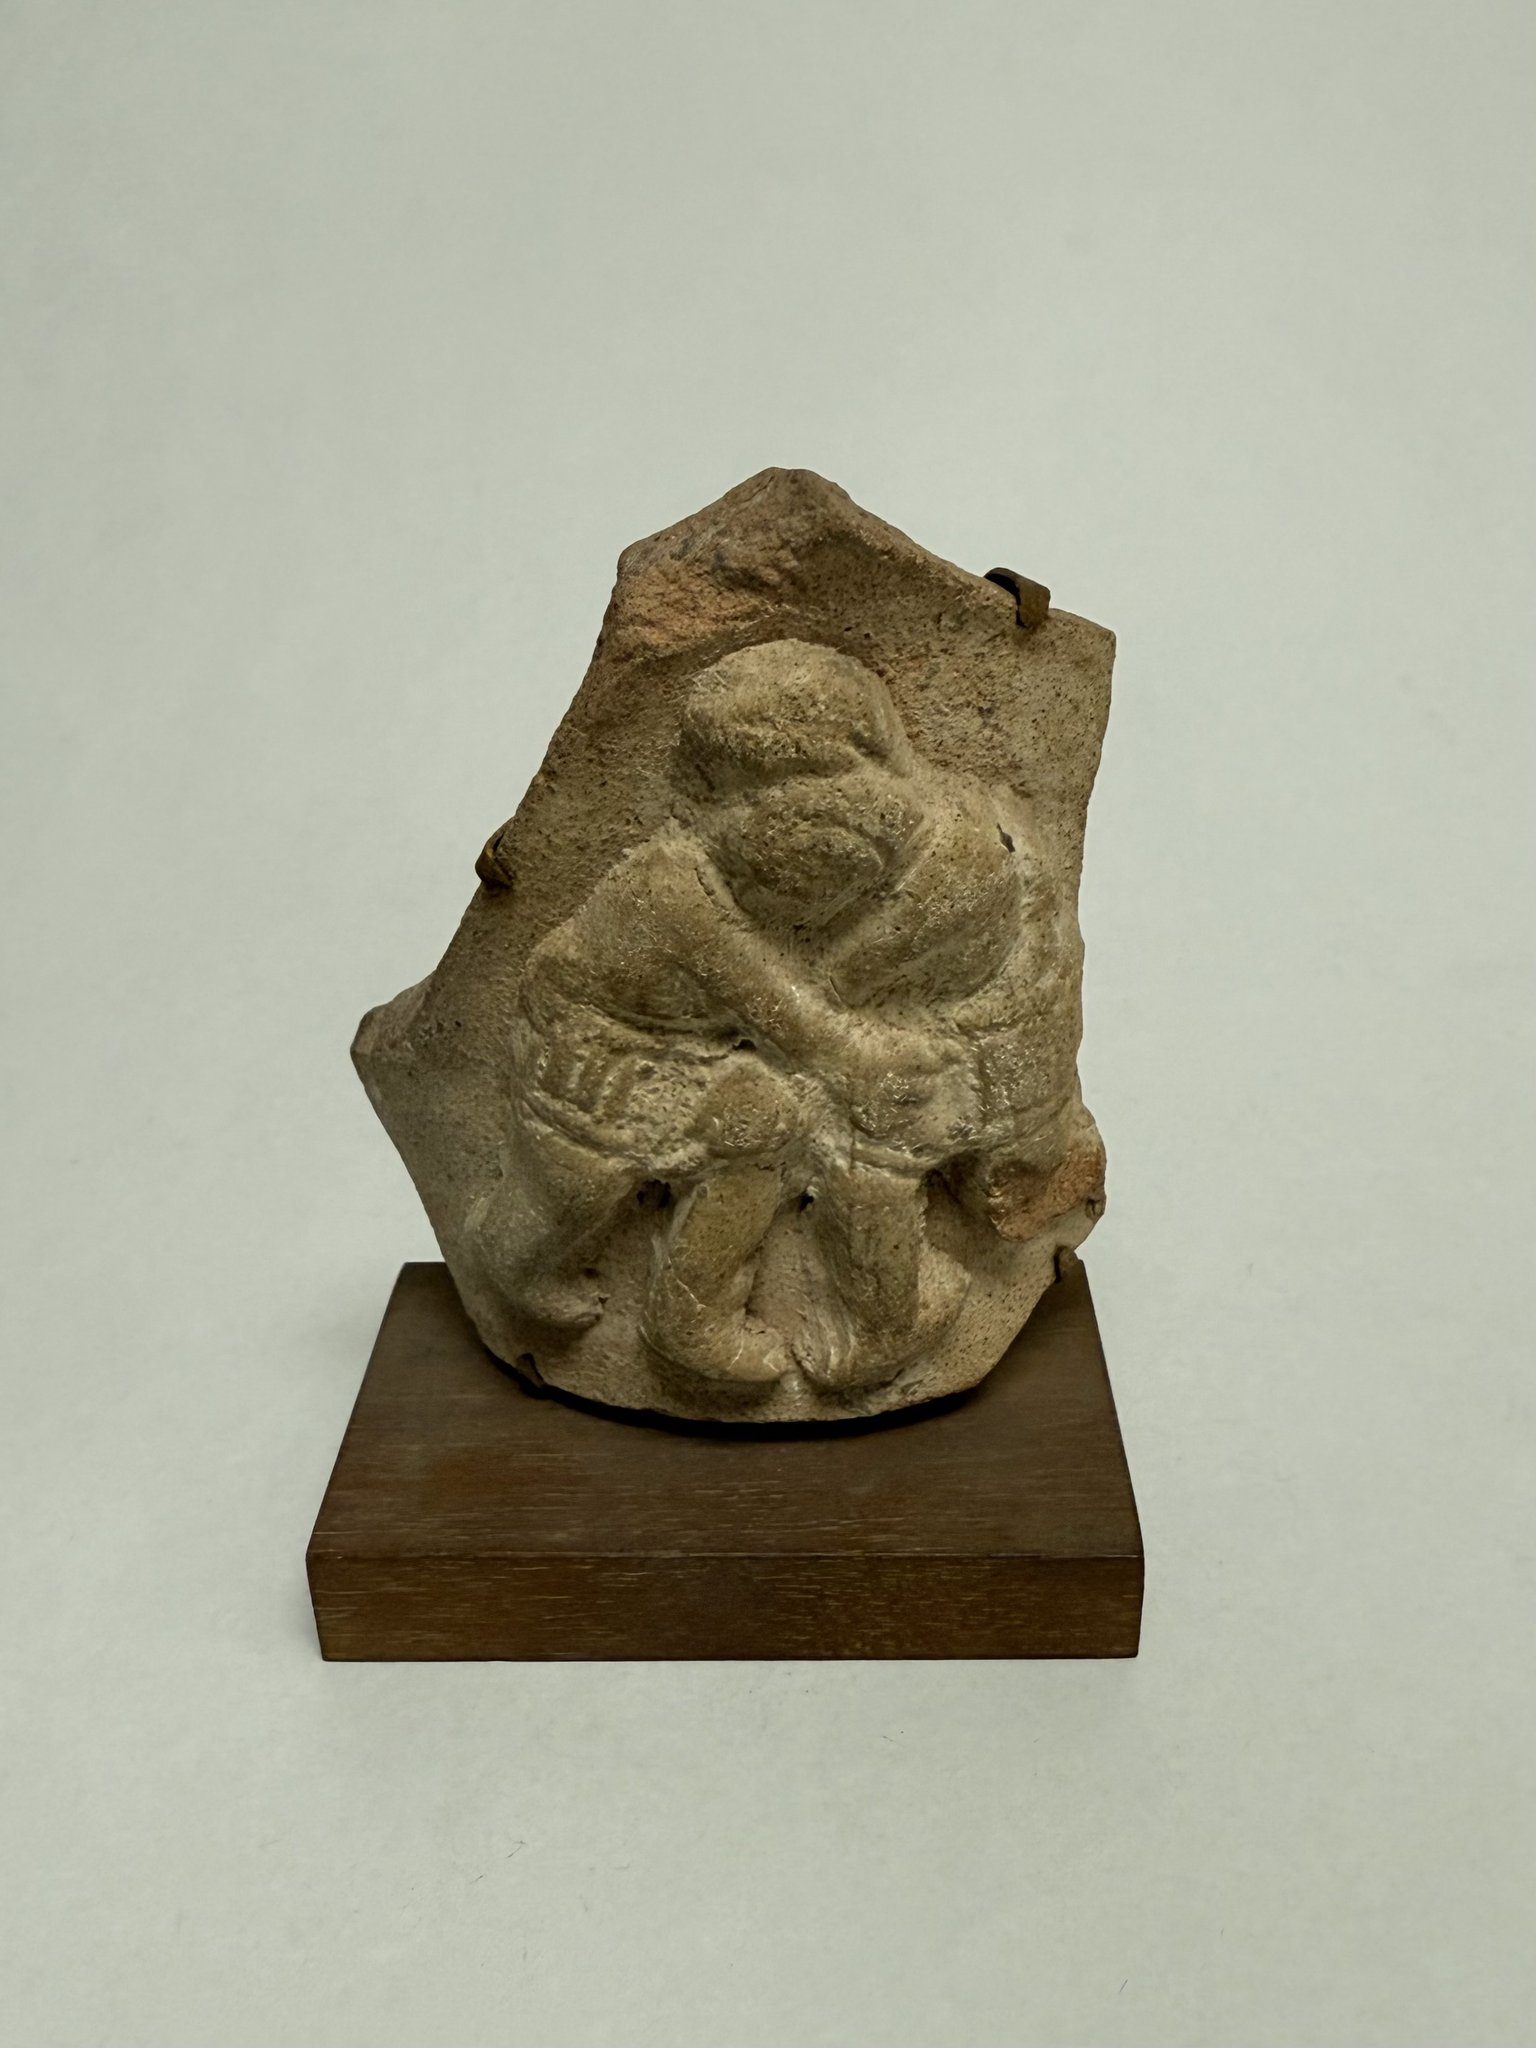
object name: shard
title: Shard: Two Wrestlers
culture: central asian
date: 1101-1133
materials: earthenware